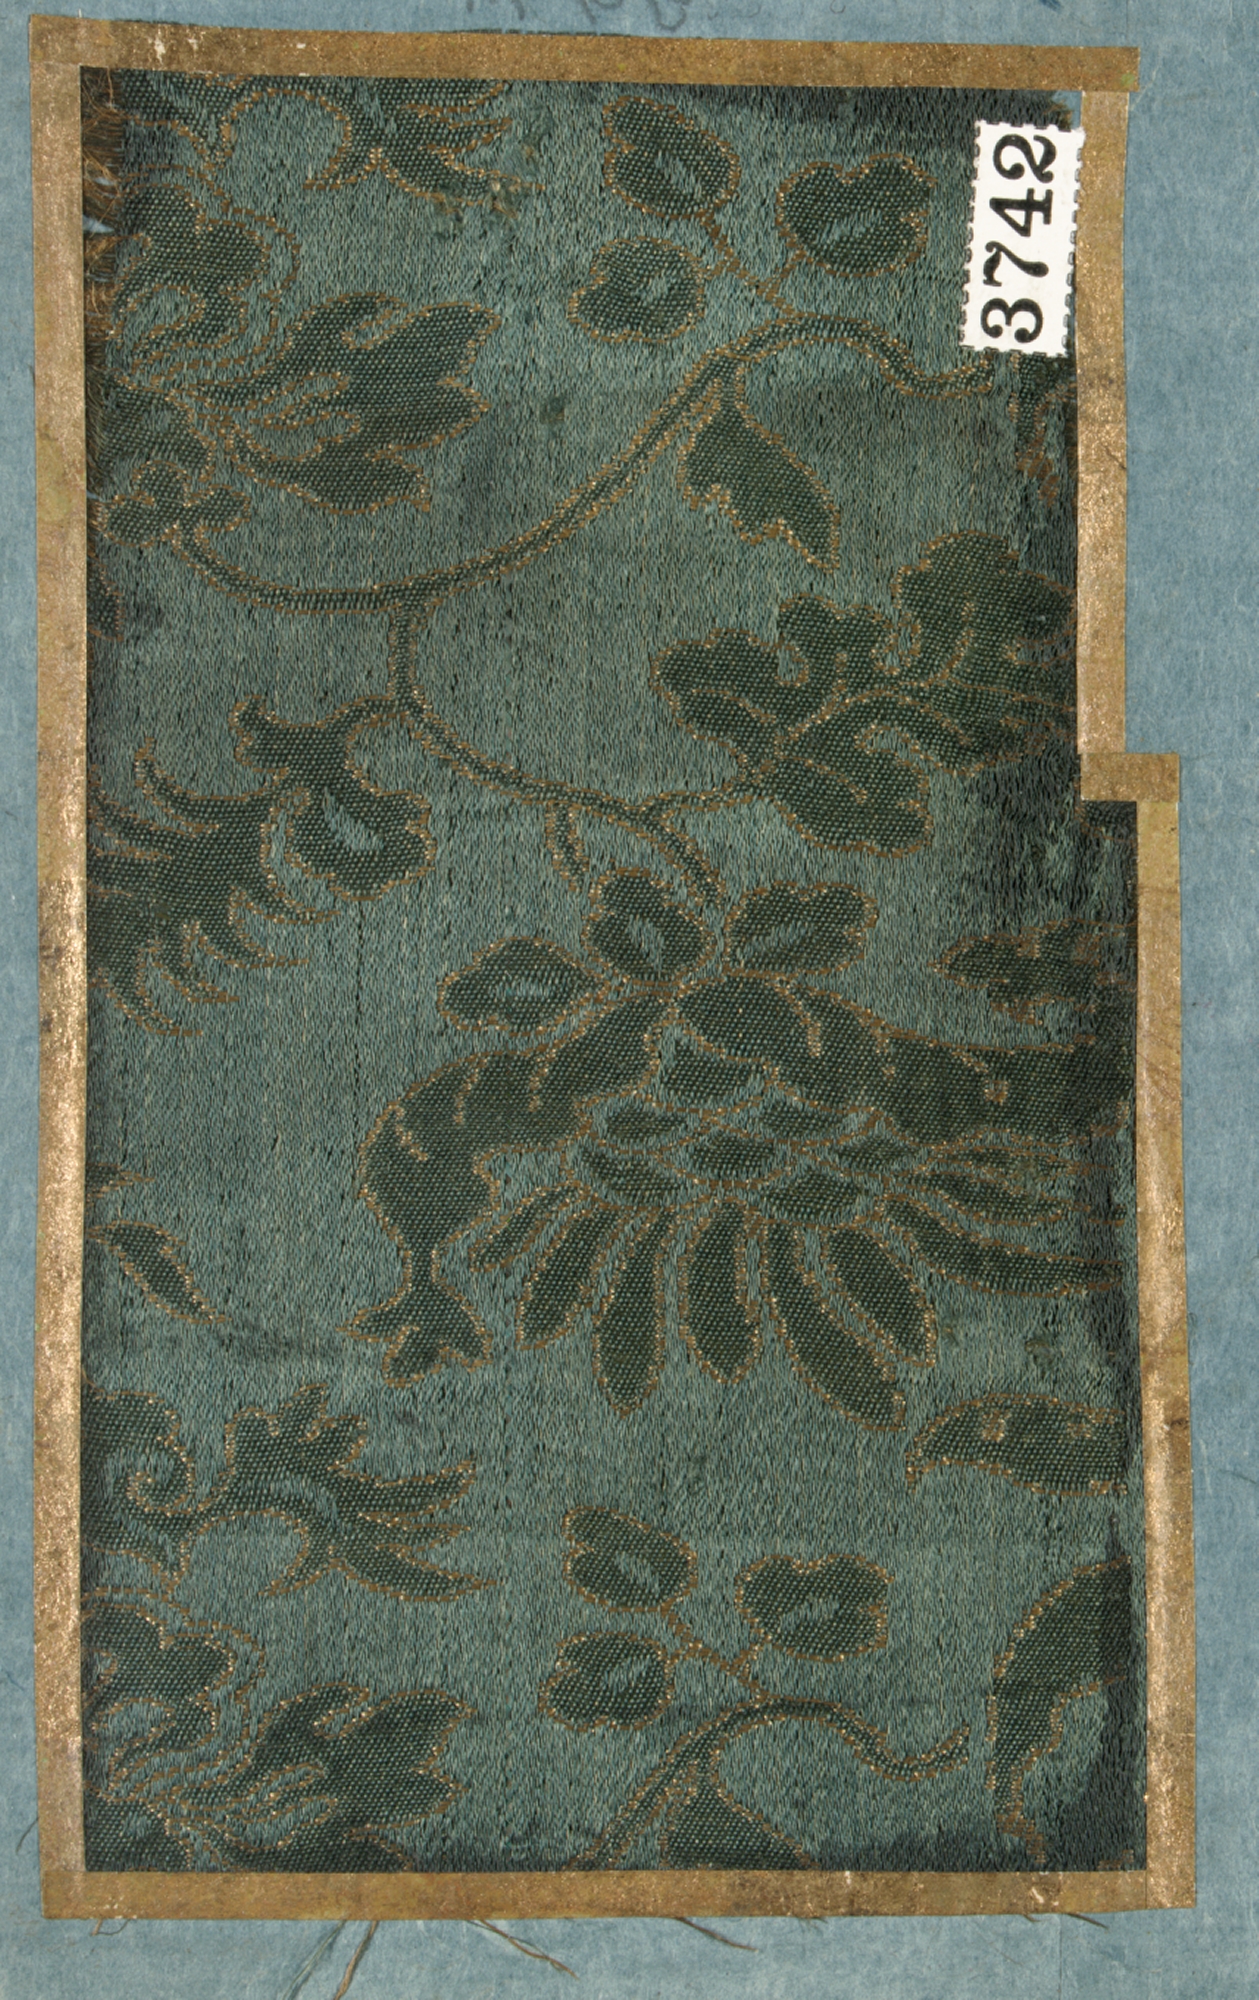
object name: sample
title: Textile Sample from Sample Book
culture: japanese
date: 1801-1900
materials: silk